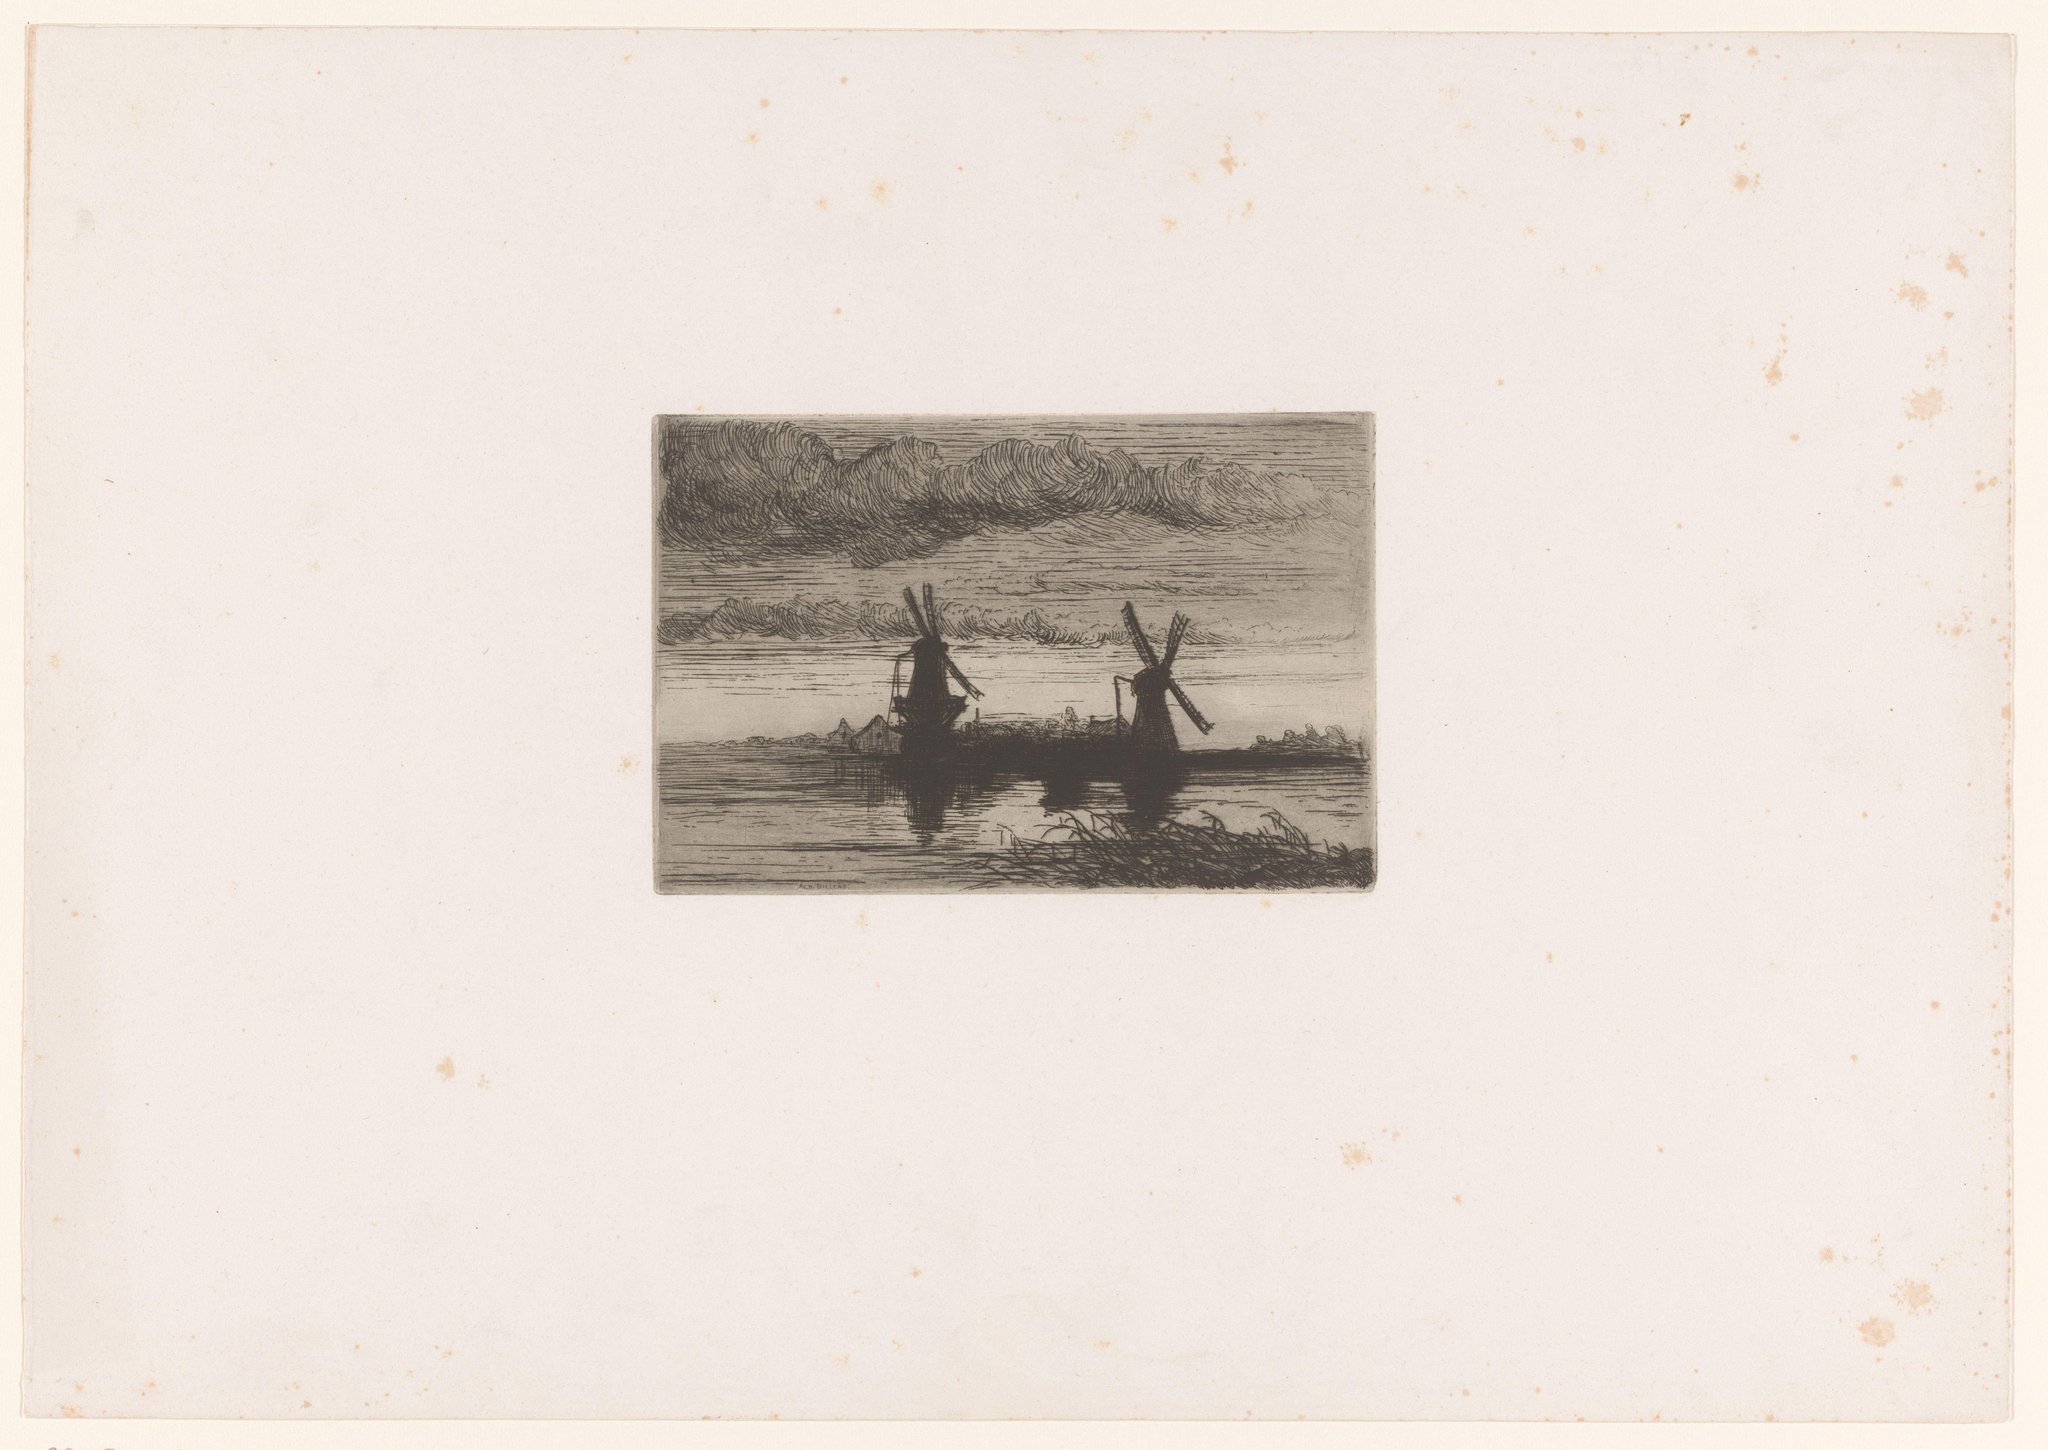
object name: print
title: Twee molens aan een waterplas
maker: albert dillens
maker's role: print maker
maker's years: 1844-1915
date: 1874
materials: paper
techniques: etching, intaglio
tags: windmill in landscape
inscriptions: collector's mark: Lugt 2228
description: Prent verschenen in: Album du journal des Beaux-Arts, dix eaux-fortes inédites. Brussel: Decq et al., 1874.